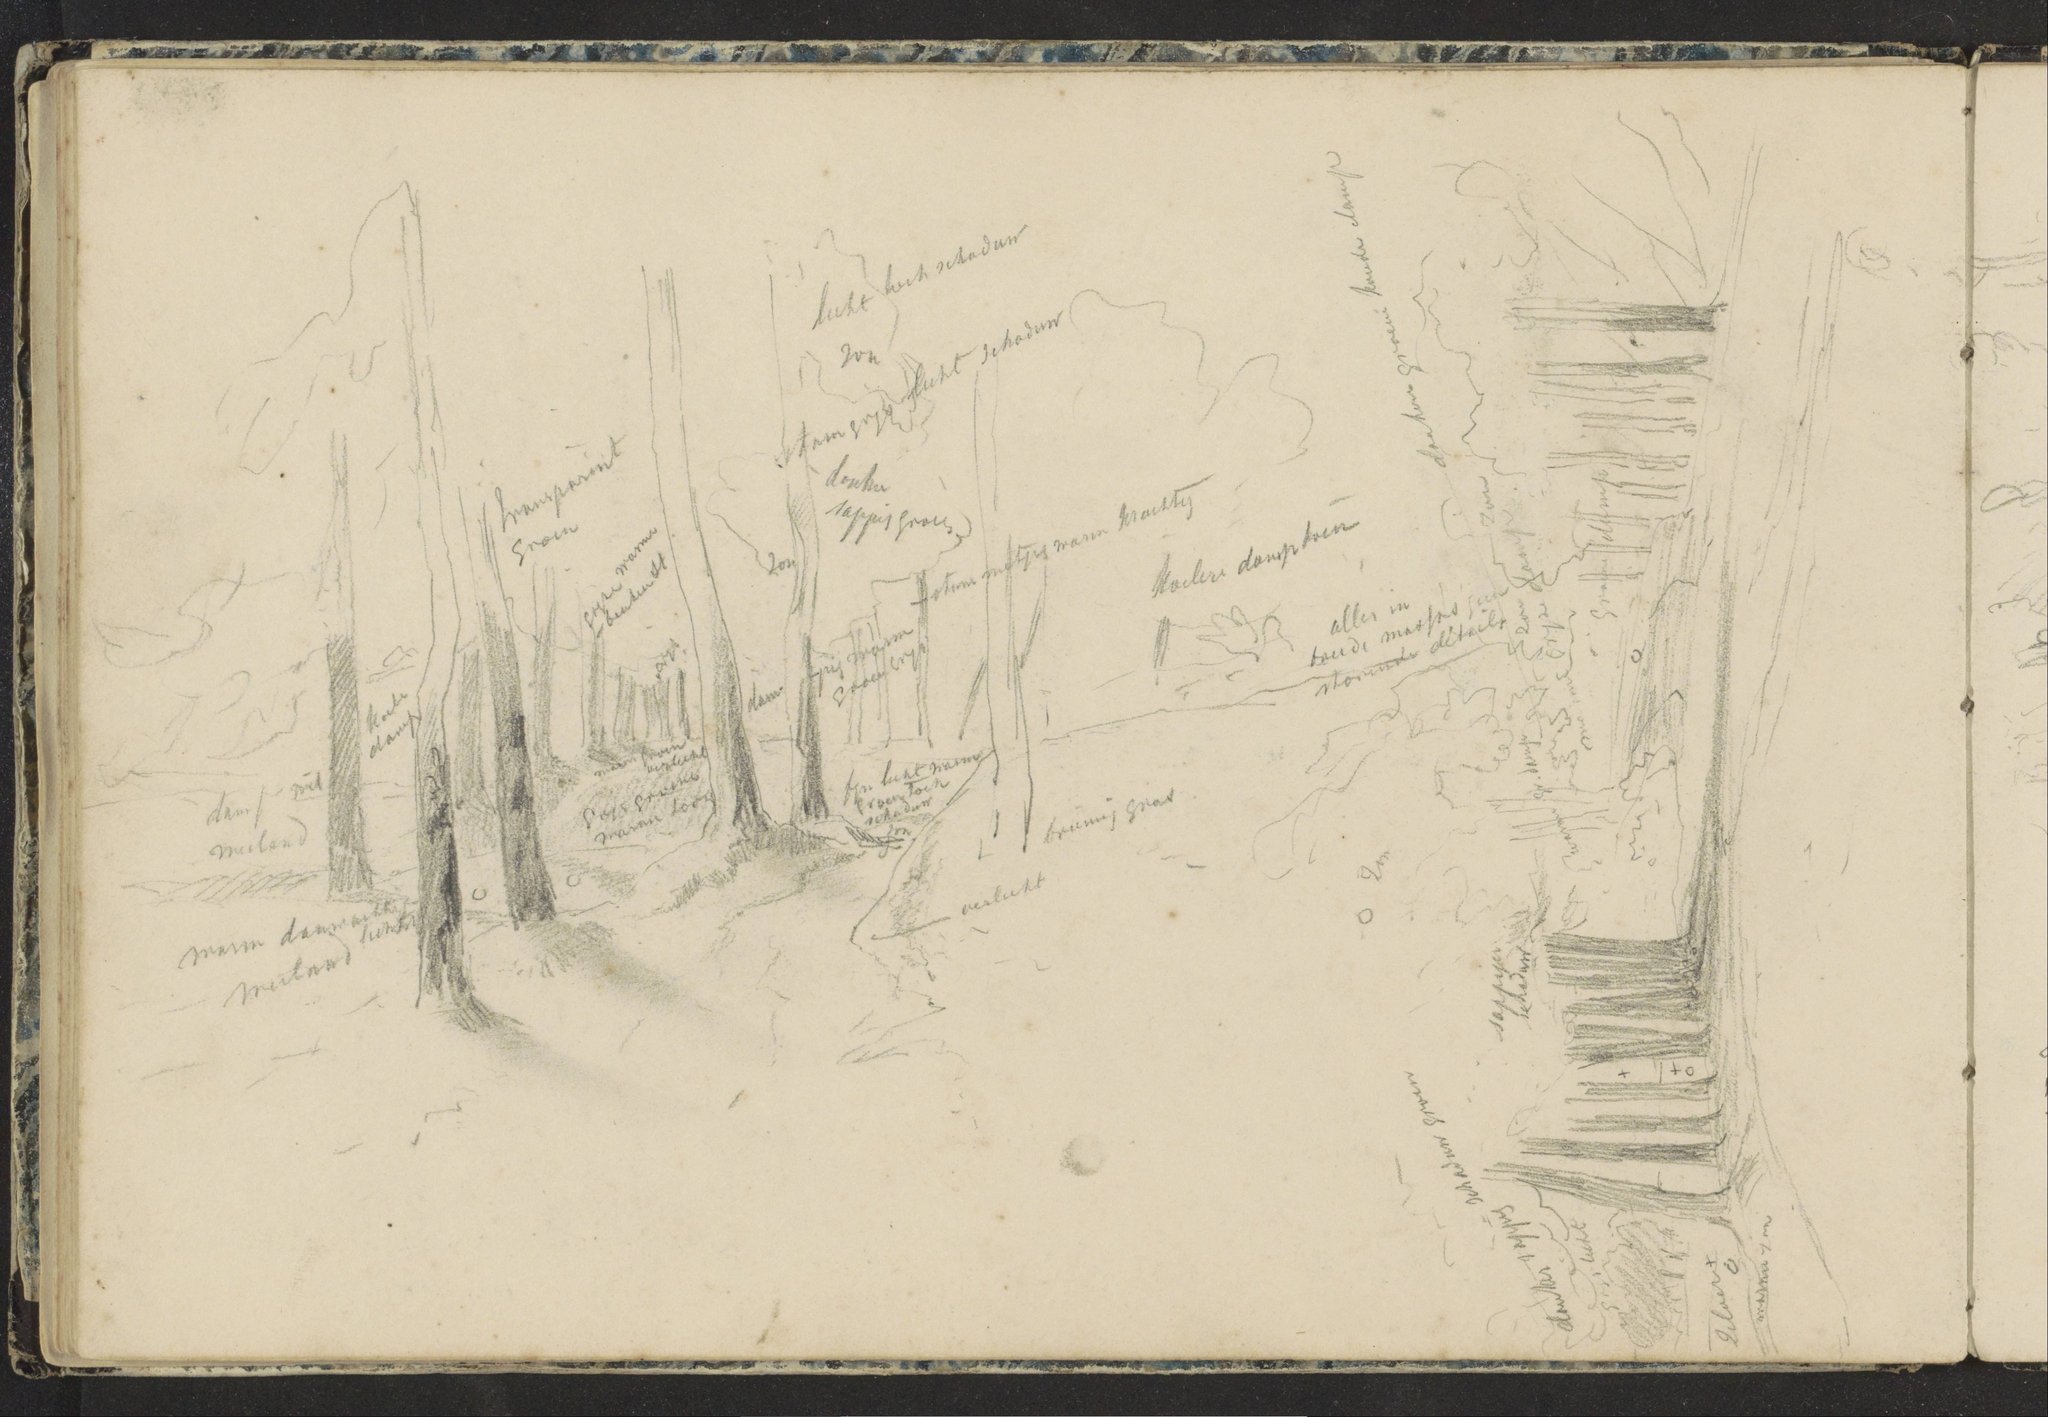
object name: sketchbook leaf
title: Bospaden bij Rozendaal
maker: johannes tavenraat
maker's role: draughtsman, painter, print maker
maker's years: 1809-1881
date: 1843-1857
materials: paper, pencil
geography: rozendaal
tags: forest, wood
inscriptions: kleurnotitie, handgeschreven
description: Blad 28 verso uit een schetsboek met 44 bladen.